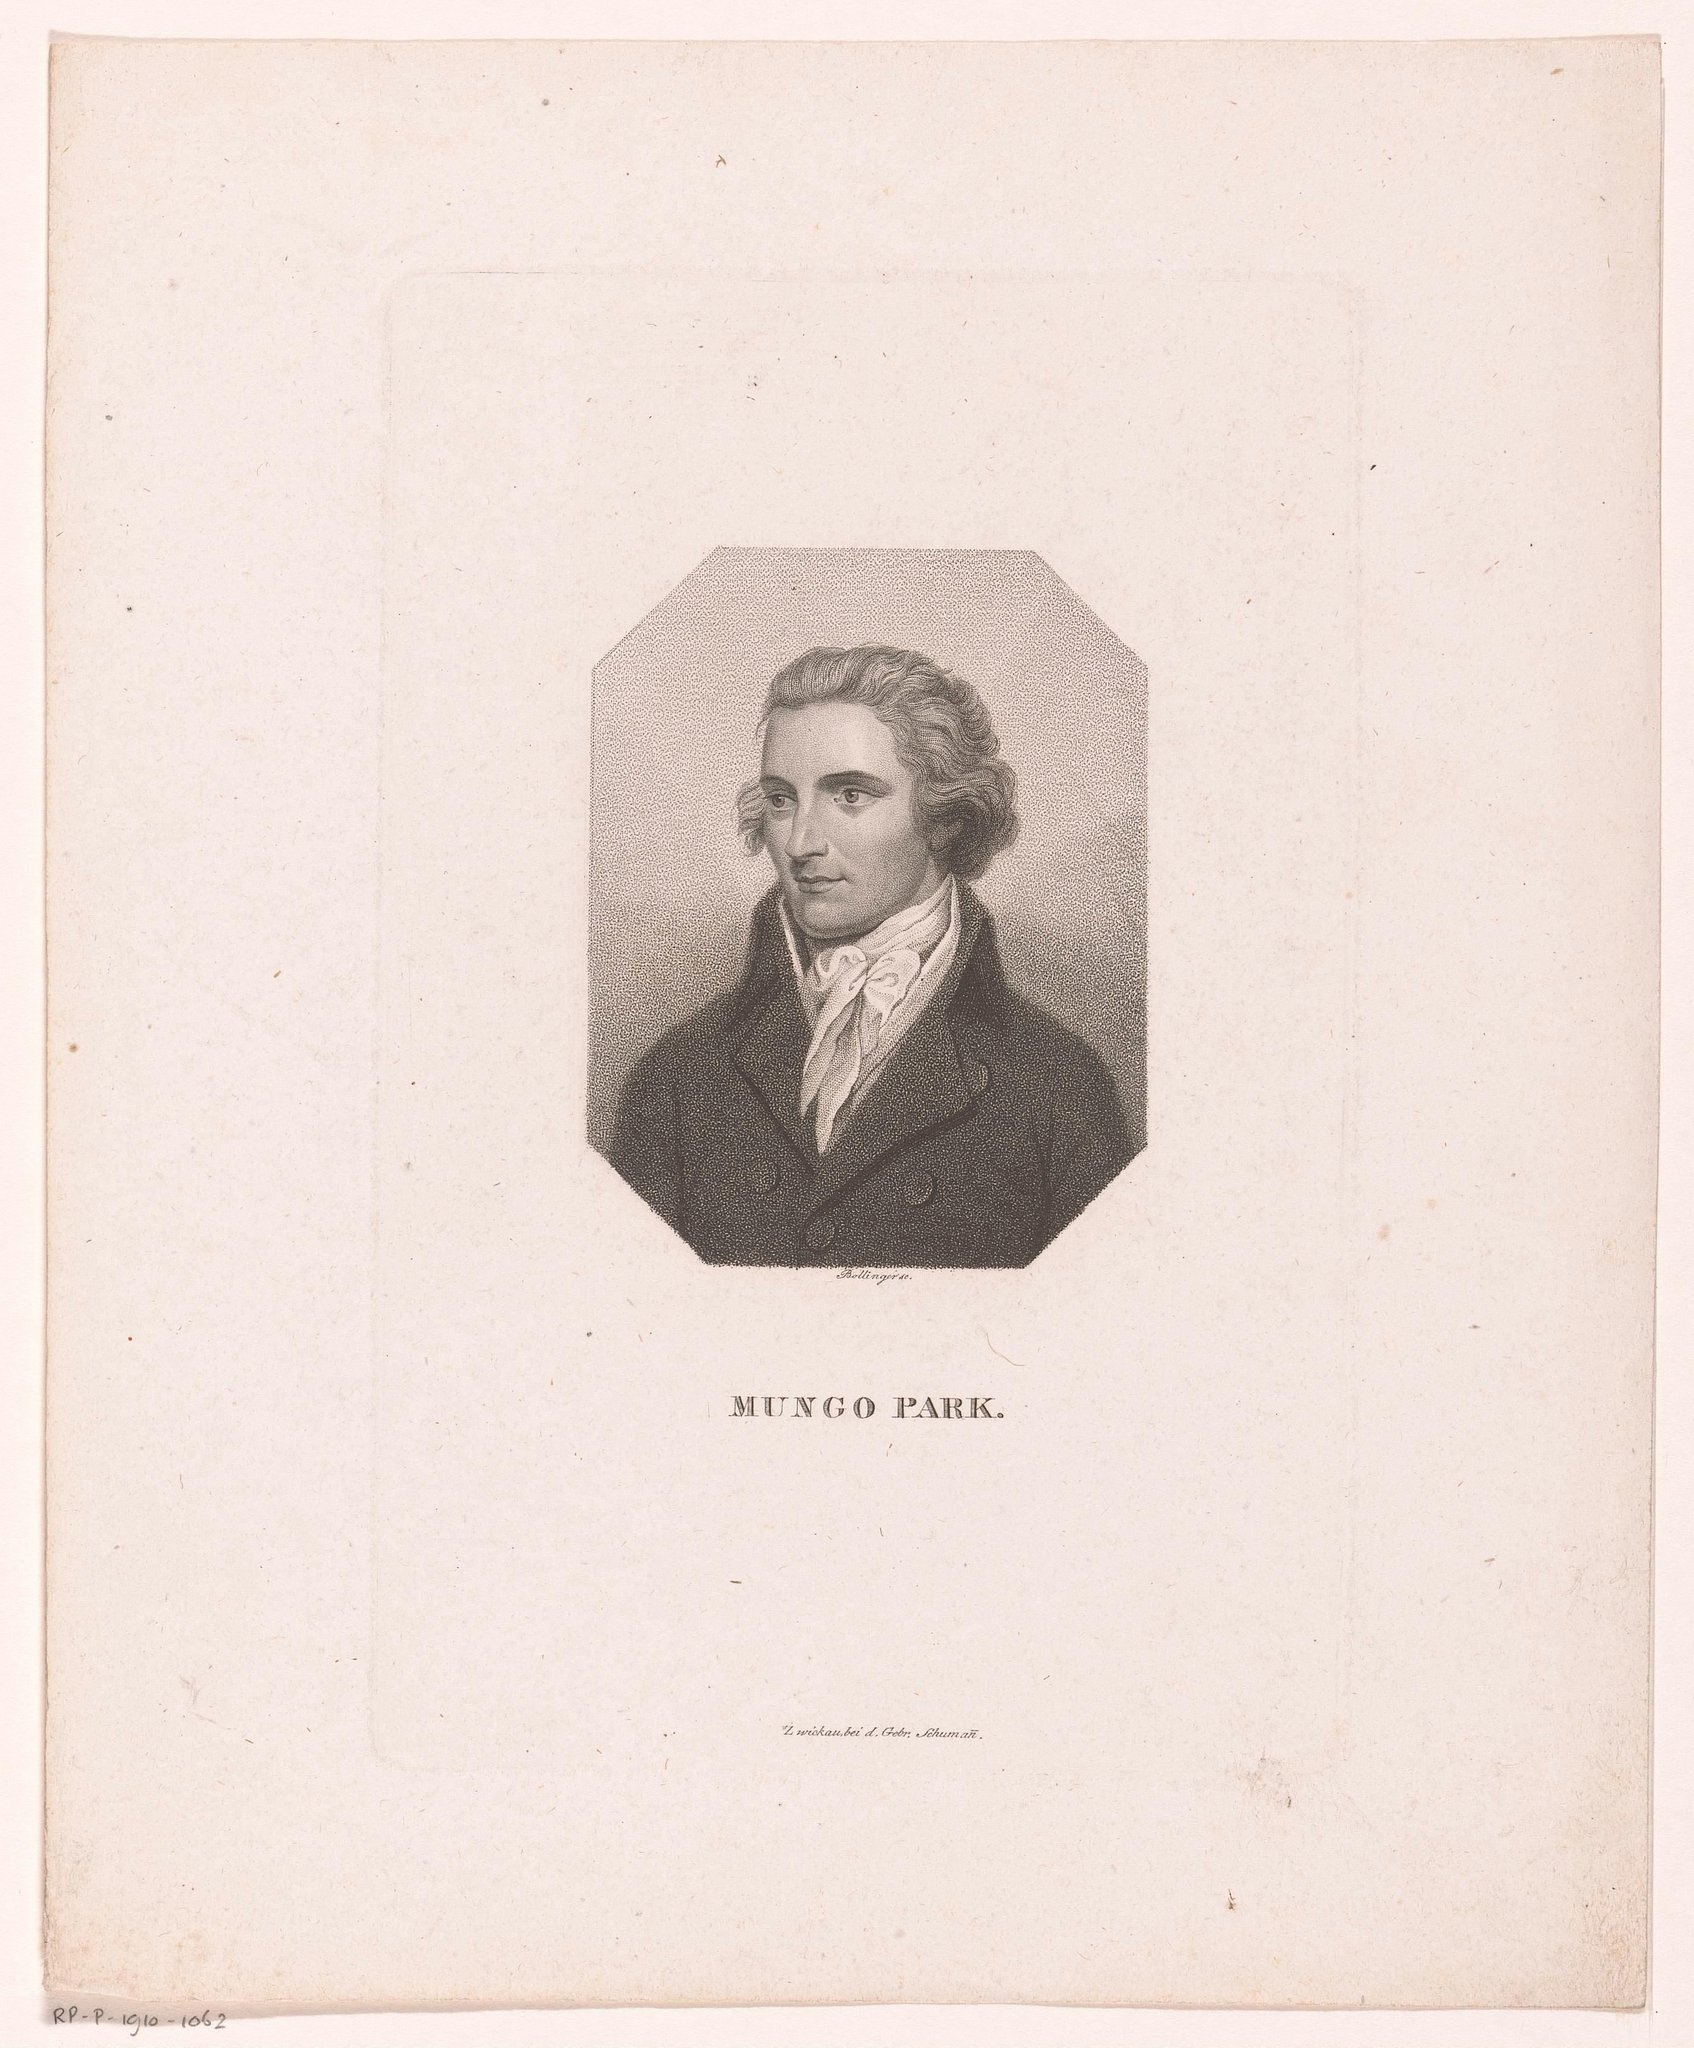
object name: print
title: Portretten van beroemde mensen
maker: friedrich wilhelm bollinger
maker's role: print maker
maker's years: 1777-1825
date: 1818-1832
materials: paper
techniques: stippling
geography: berlin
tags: historical persons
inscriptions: collector's mark: Lugt 2228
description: Prent gebruikt door de serie 'Bildnisse der berühmtesten Menschen aller Völker und Zeiten' van de gebroeders Schumann, uitgegeven in 1818-1832 te Zwickau.